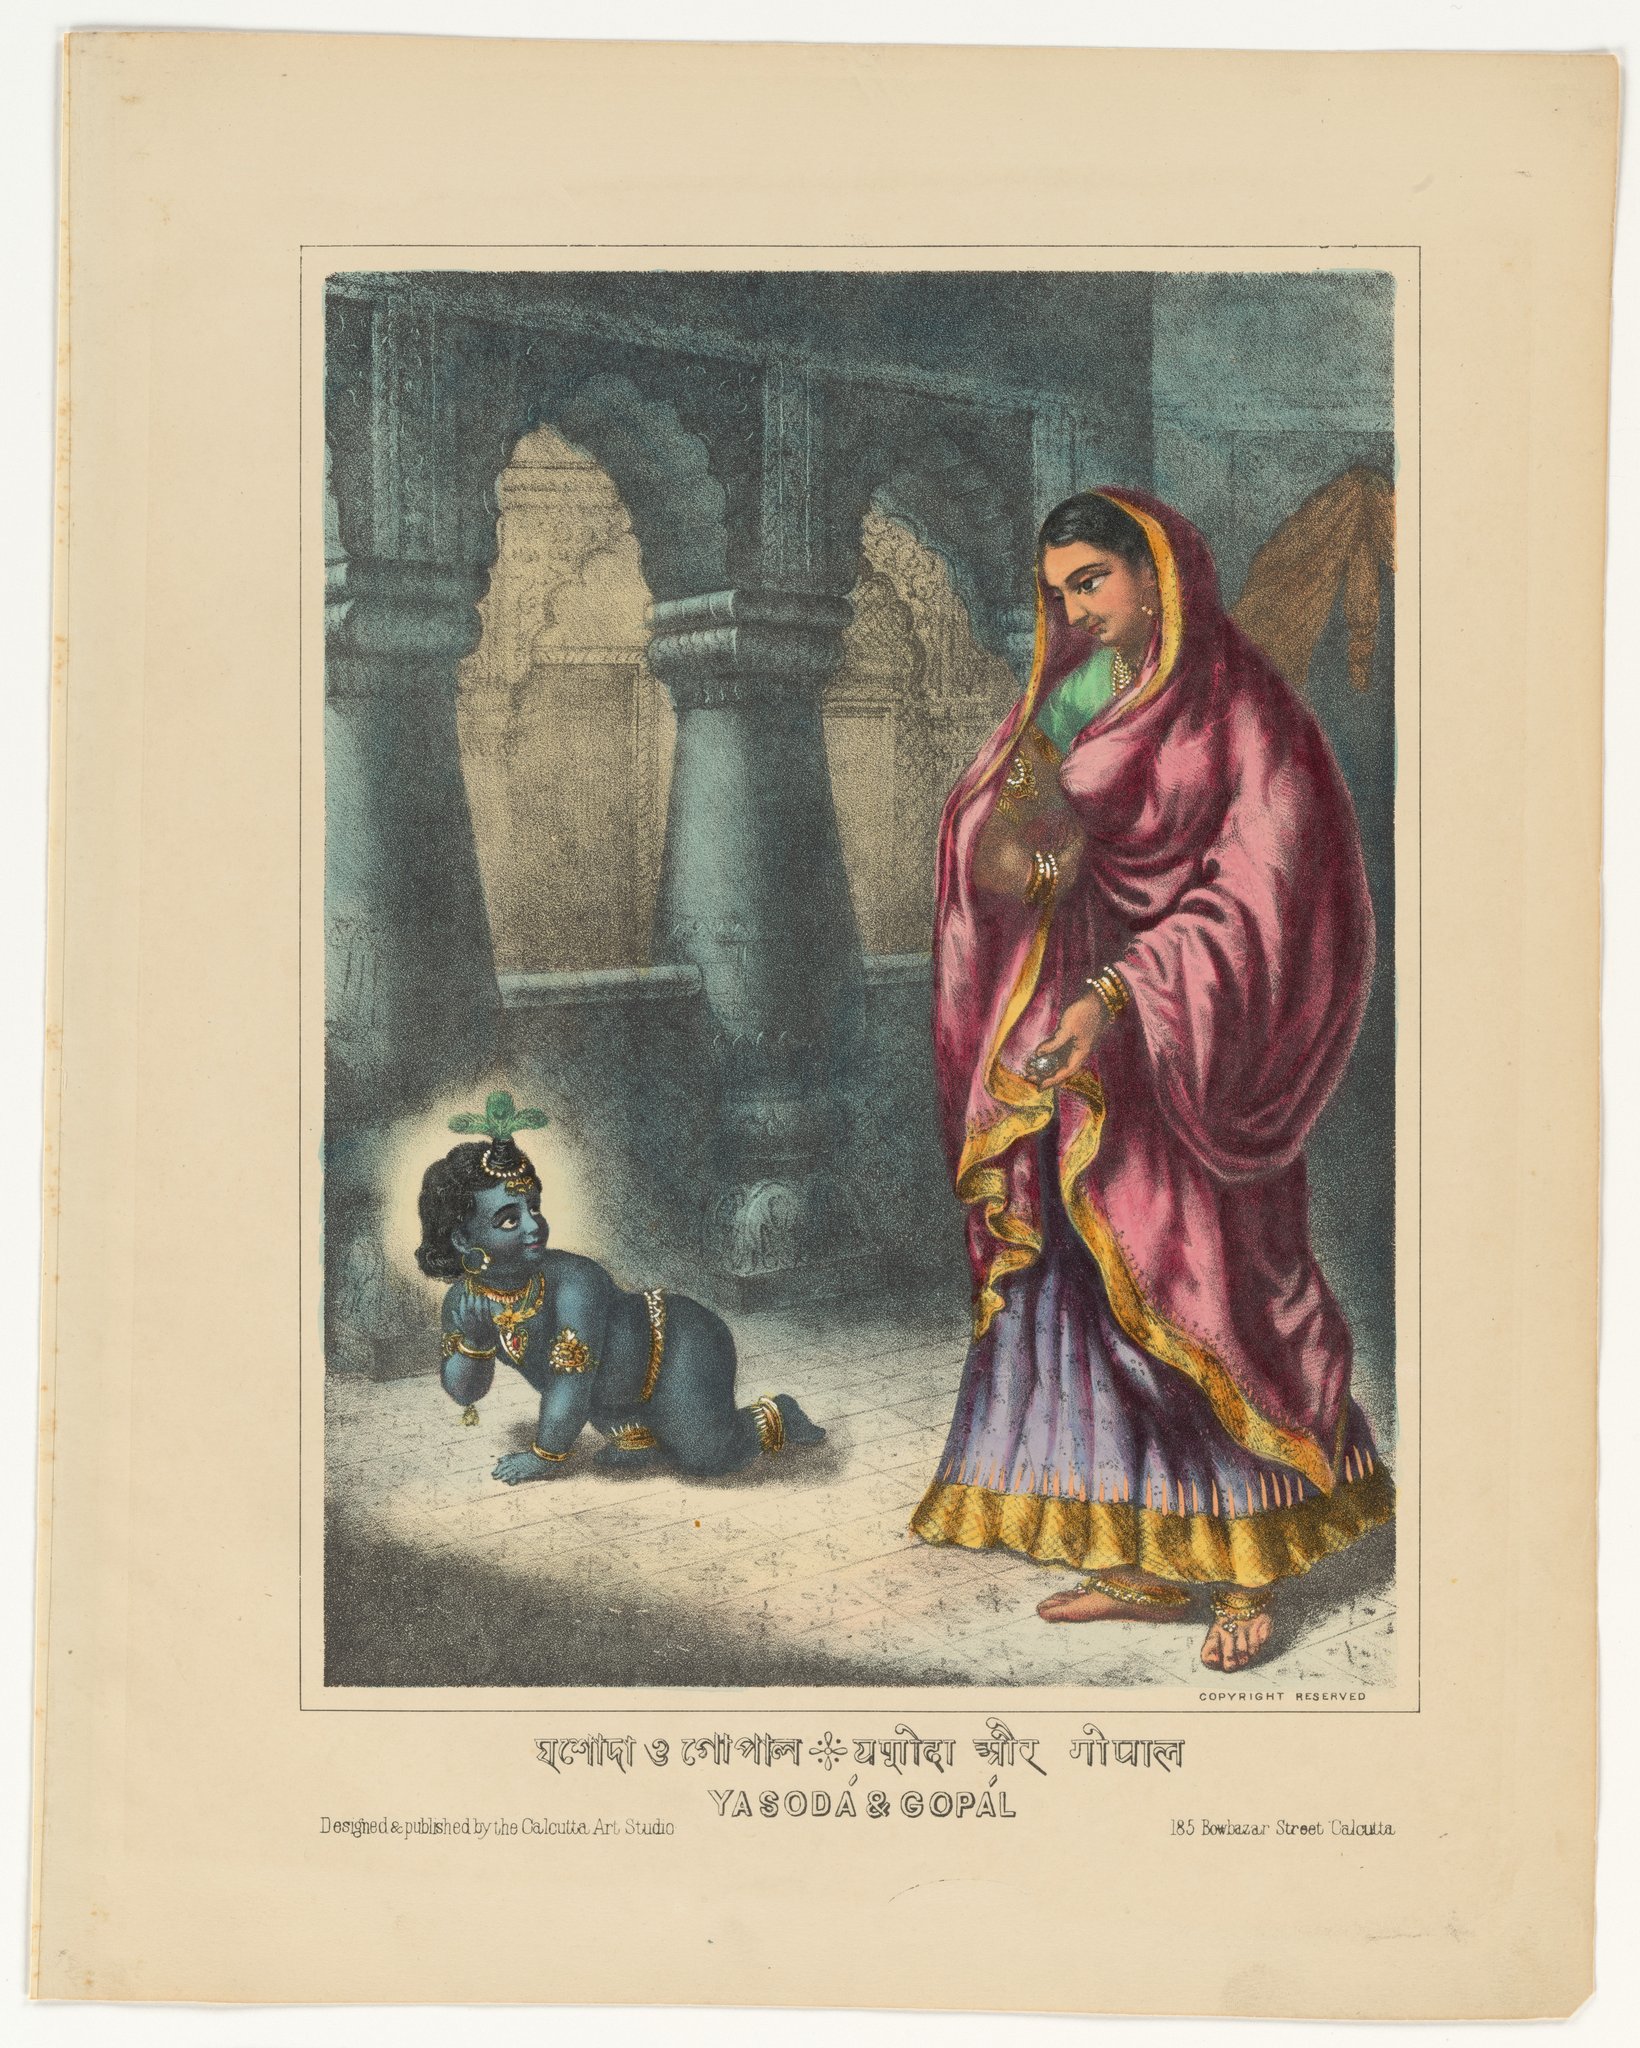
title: Yashoda and Gopal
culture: west bengali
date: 1878-1883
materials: glaze, watercolor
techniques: hand coloring, lithograph, printing